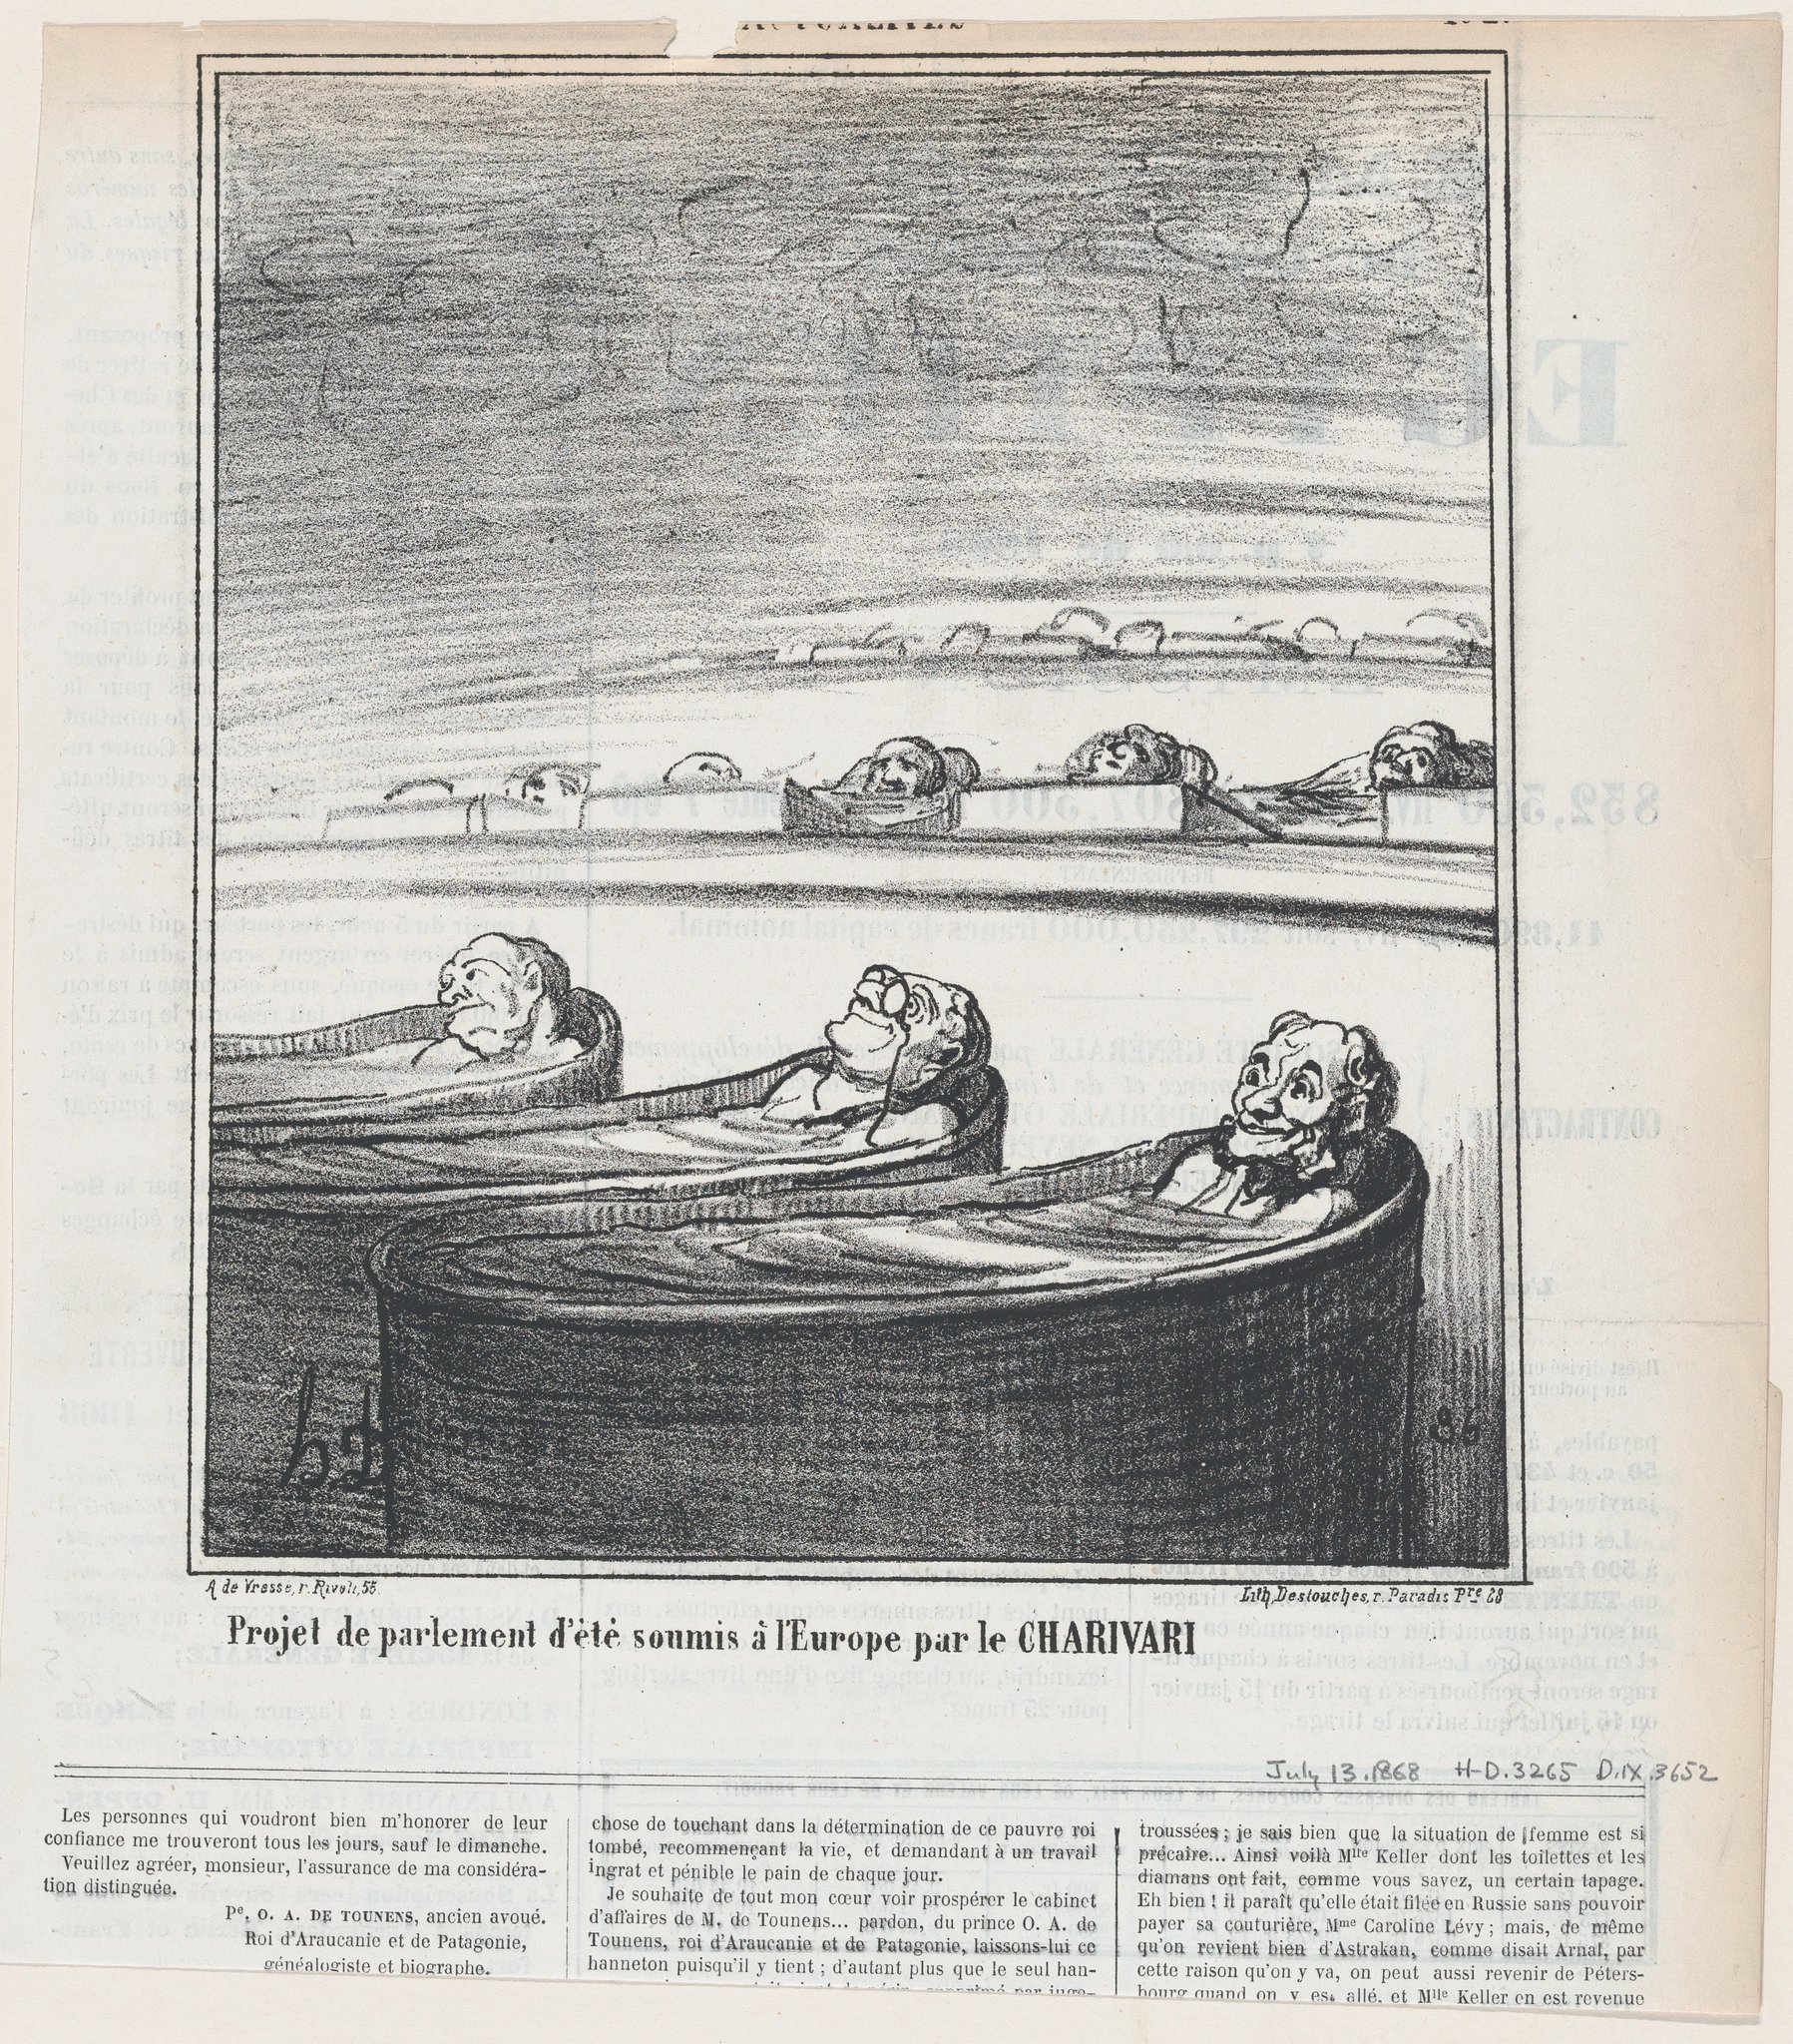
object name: print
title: Idea for summer parliament submitted to Europe by the Charivari, from 'News of the day,' published in Le Charivari, July 13, 1868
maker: honoré daumier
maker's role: artist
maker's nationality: french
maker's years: 1808-1879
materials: paper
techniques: lithograph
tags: satire,men,bathing